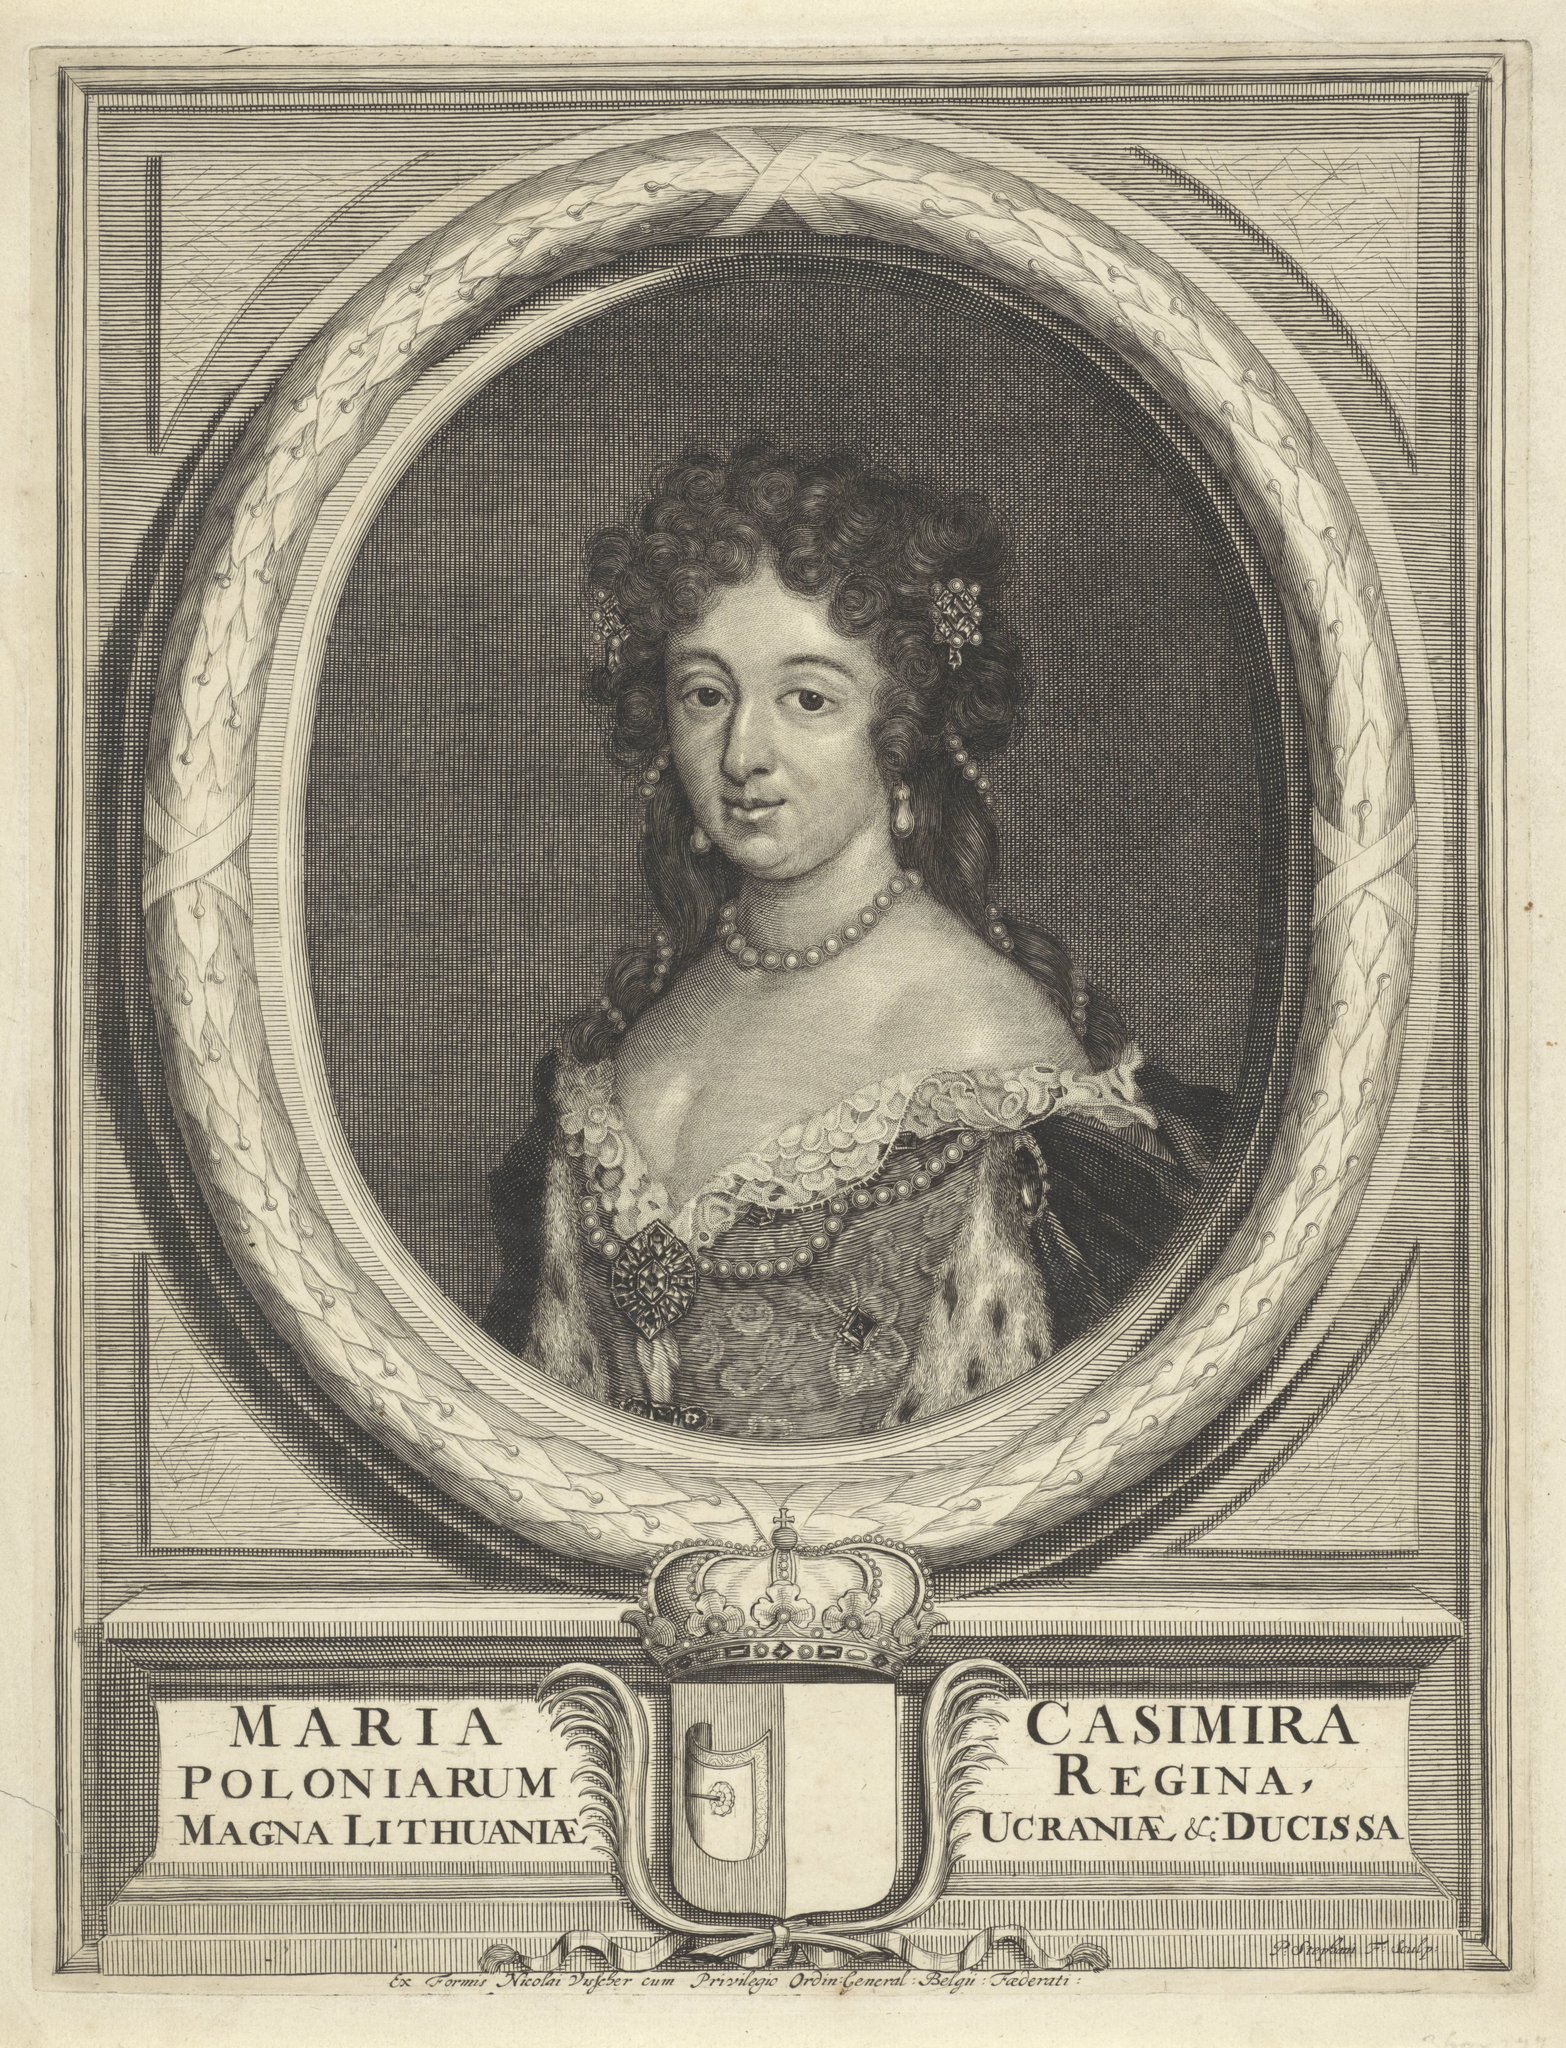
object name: print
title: Portret van Maria Casimira Ludovica, koningin van Polen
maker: pieter stevens (vermeld in 1689)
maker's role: print maker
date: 1674-1702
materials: paper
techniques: engraving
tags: queen, empress, etc. (wife of a ruler)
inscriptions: collector's mark: Lugt 2228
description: Portret van Maria Casimira Ludovica, koningin van Polen, met een parelsnoer om haar hals en sieraden in het haar. Midden onder haar gekroonde wapenschild.